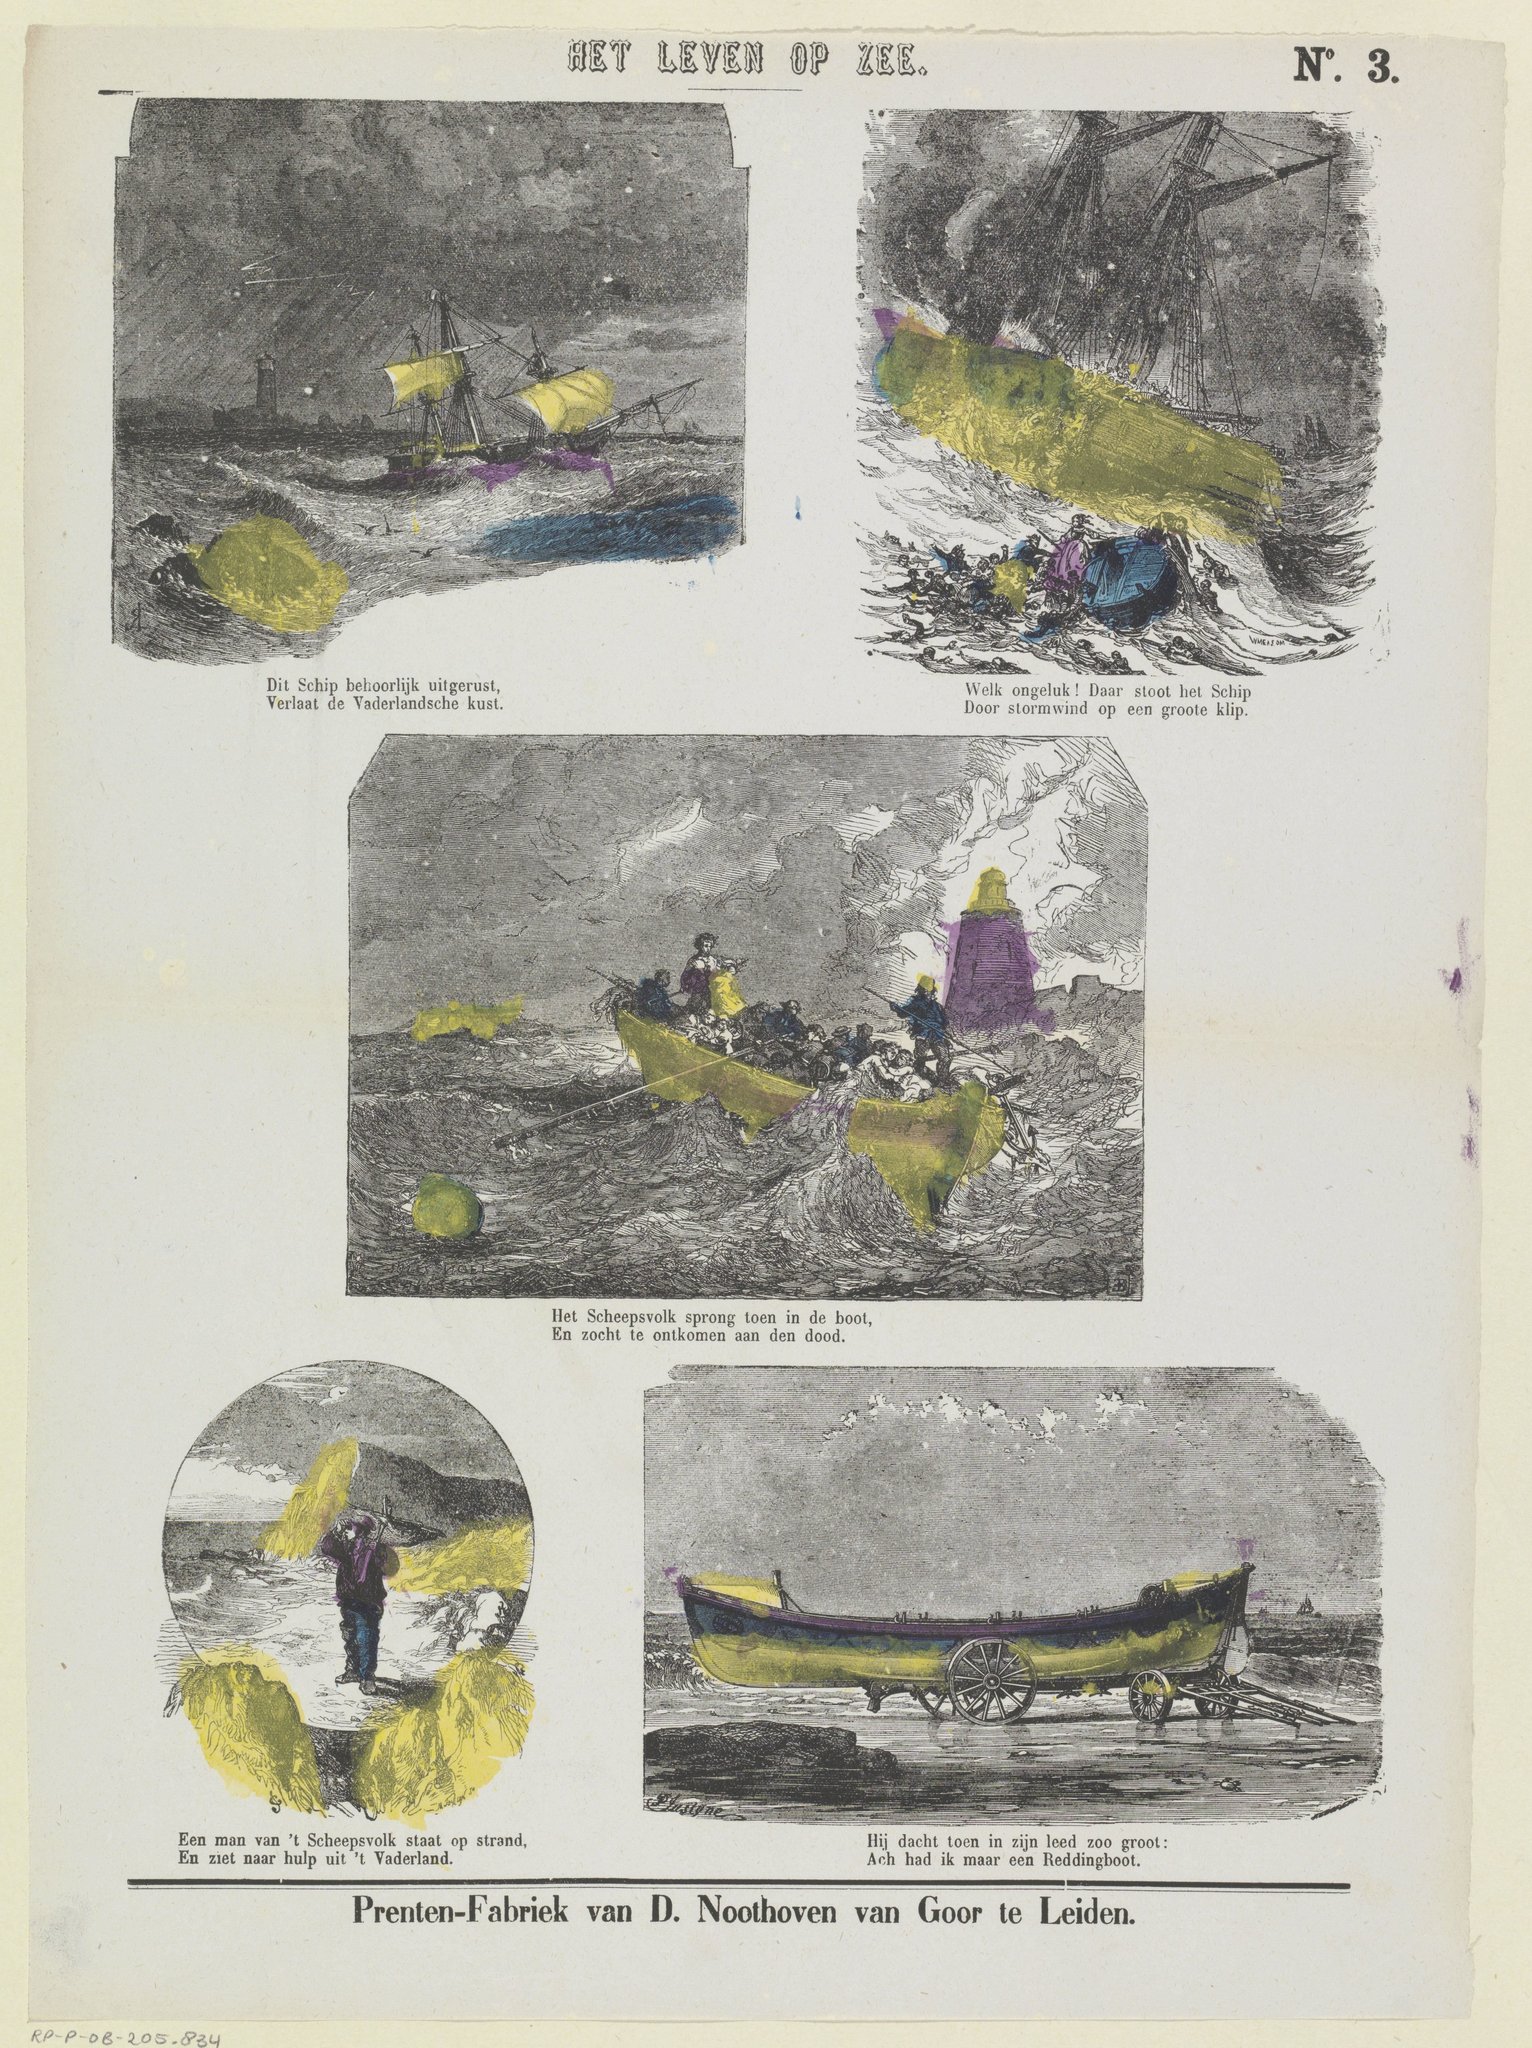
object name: popular print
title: Het leven op zee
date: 1850-1881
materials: paper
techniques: colour, letterpress printing, engraving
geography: leiden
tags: lifeboat, shipwreck, sailor, storm at sea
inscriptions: collector's mark: Lugt 2760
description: Blad met 5 voorstellingen van schepen tijdens een storm op zee, gestrande zeelieden en van een reddingsboot. Onder elke voorstelling een tweeregelig vers. Genummerd rechtsboven: No. 3.